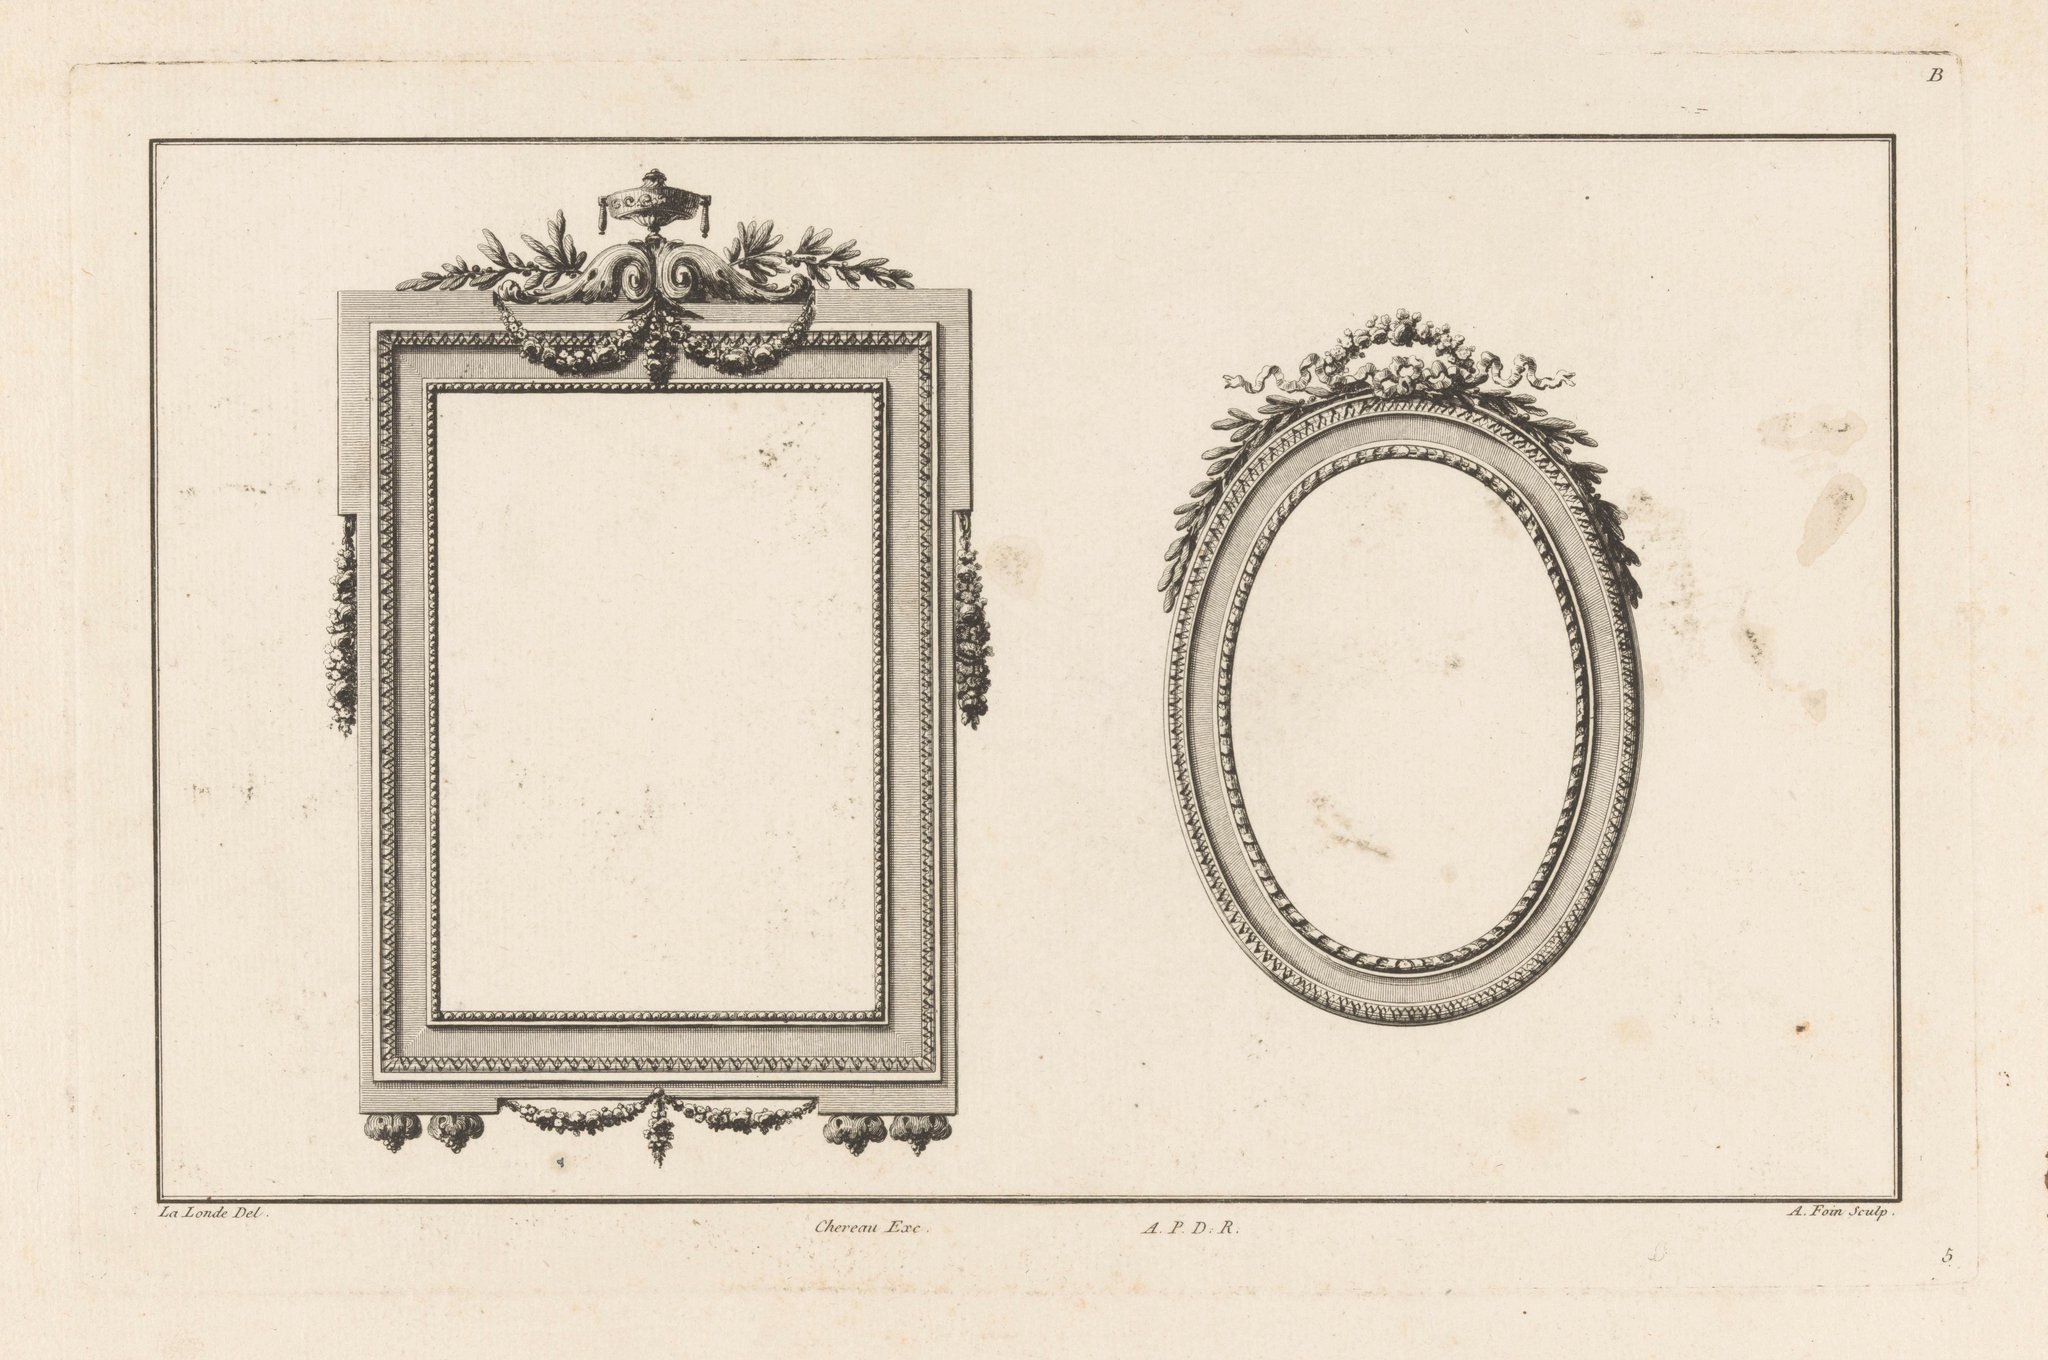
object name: ornament print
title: B Cahier de Bordures et de Cadres, de differentes formes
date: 1784-1785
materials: paper, pencil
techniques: engraving, etching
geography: paris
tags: ornaments ~ art (+ framing decorations)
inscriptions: collector's mark: Lugt 2760, collector's mark: Lugt 2228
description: Links een rechthoekige omlijsting met guirlandes en een vaas. Rechts een ovale omlijsting met takken, bloemmotieven en een lint. Verso tekening van een gezicht.